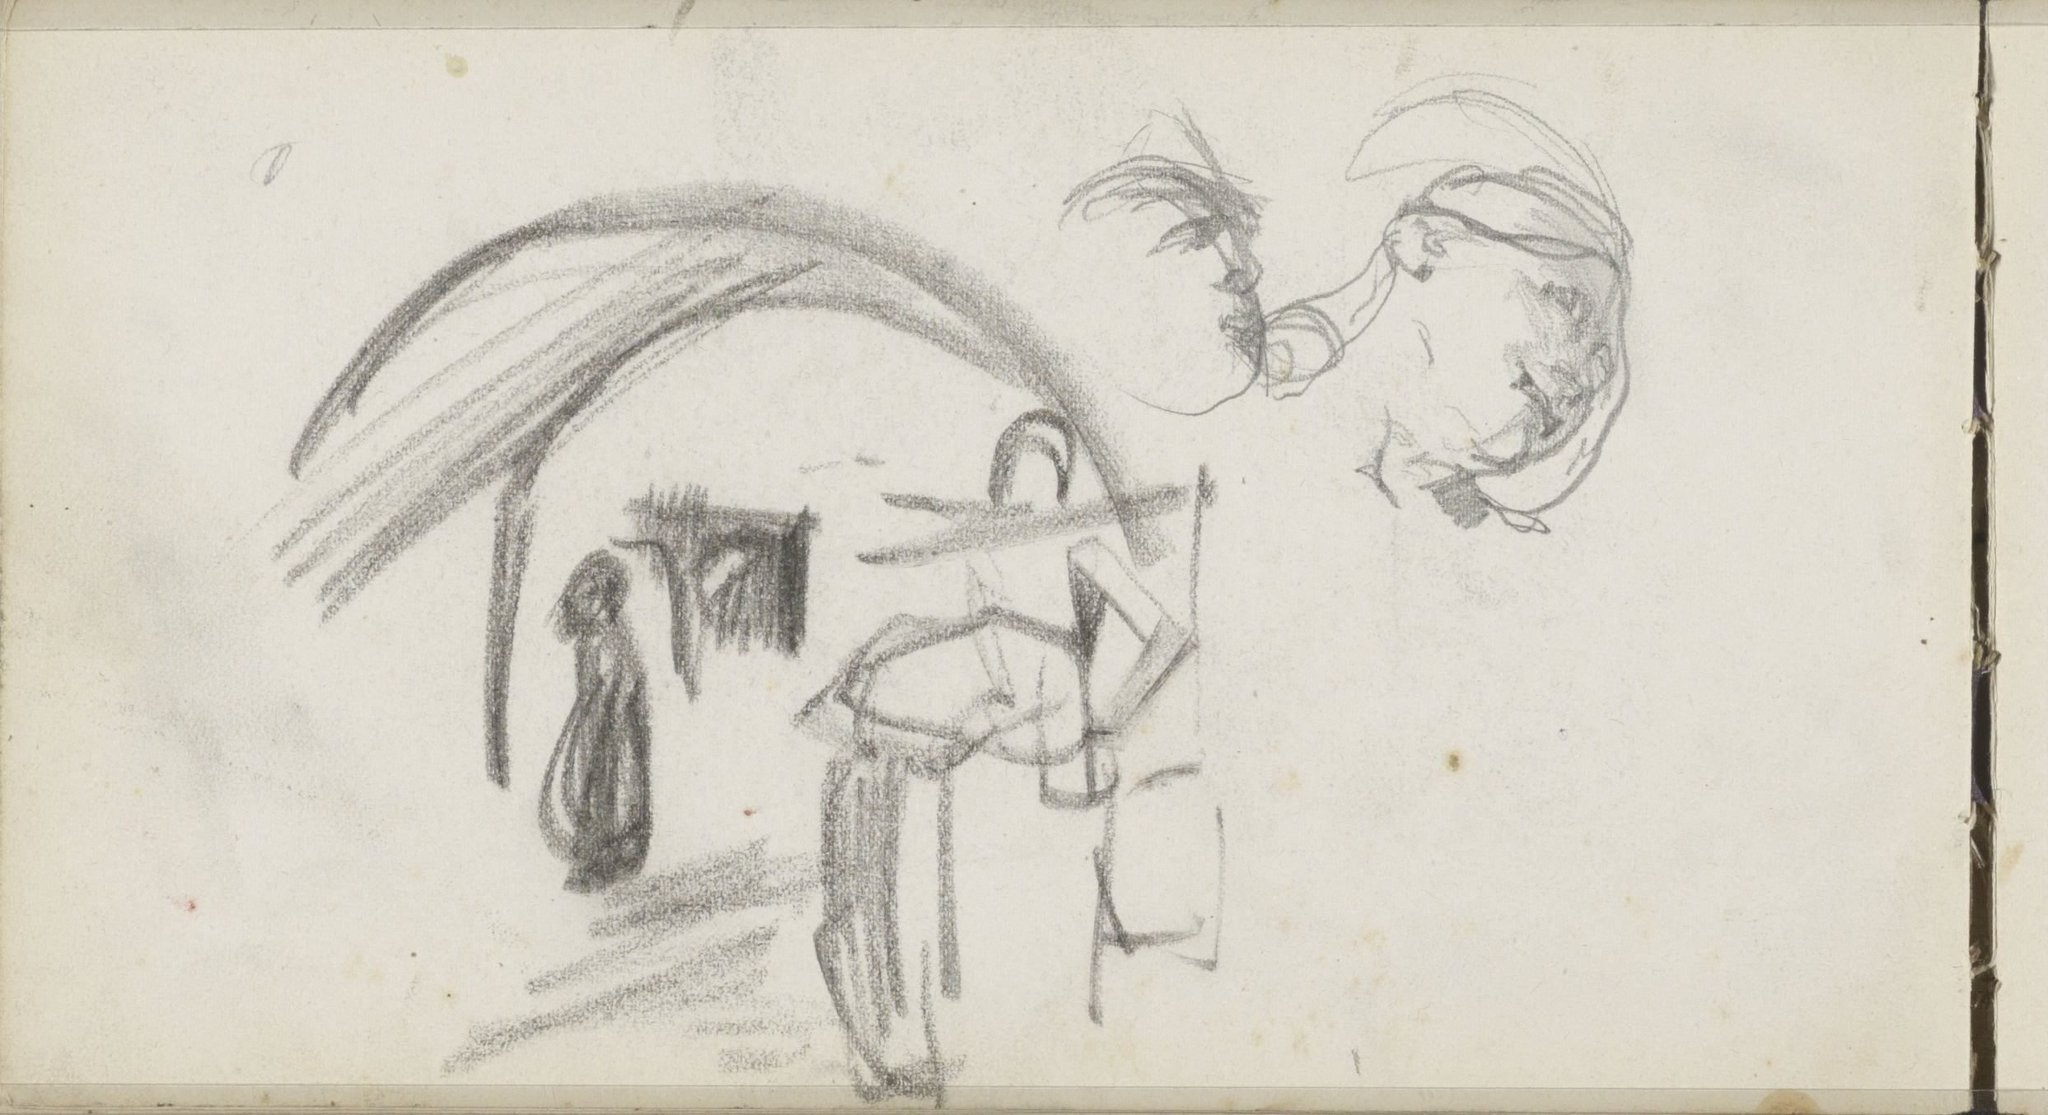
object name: sketchbook leaf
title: Vrouw en kind bij een doorgang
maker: george hendrik breitner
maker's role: draughtsman, painter, print maker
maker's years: 1857-1923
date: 1886-1923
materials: chalk, paper, pencil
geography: amsterdam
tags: head (human), adult woman, child, passage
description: De vrouw draagt mogelijk een juk. Rechts twee hoofden. Pagina 71 uit een schetsboek met 39 bladen.